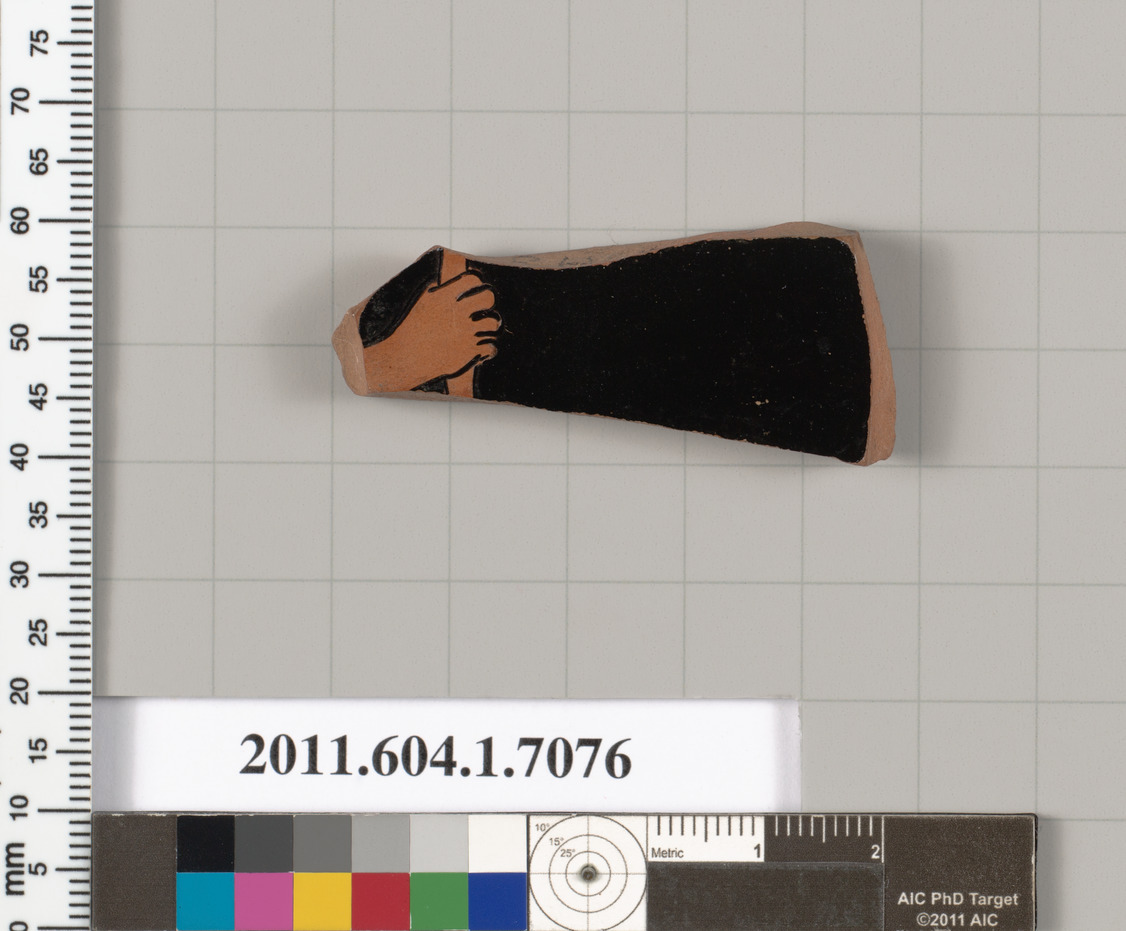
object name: kylix fragment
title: Terracotta fragment of a kylix (drinking cup)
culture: greek, attic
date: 500-480 BCE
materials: terracotta